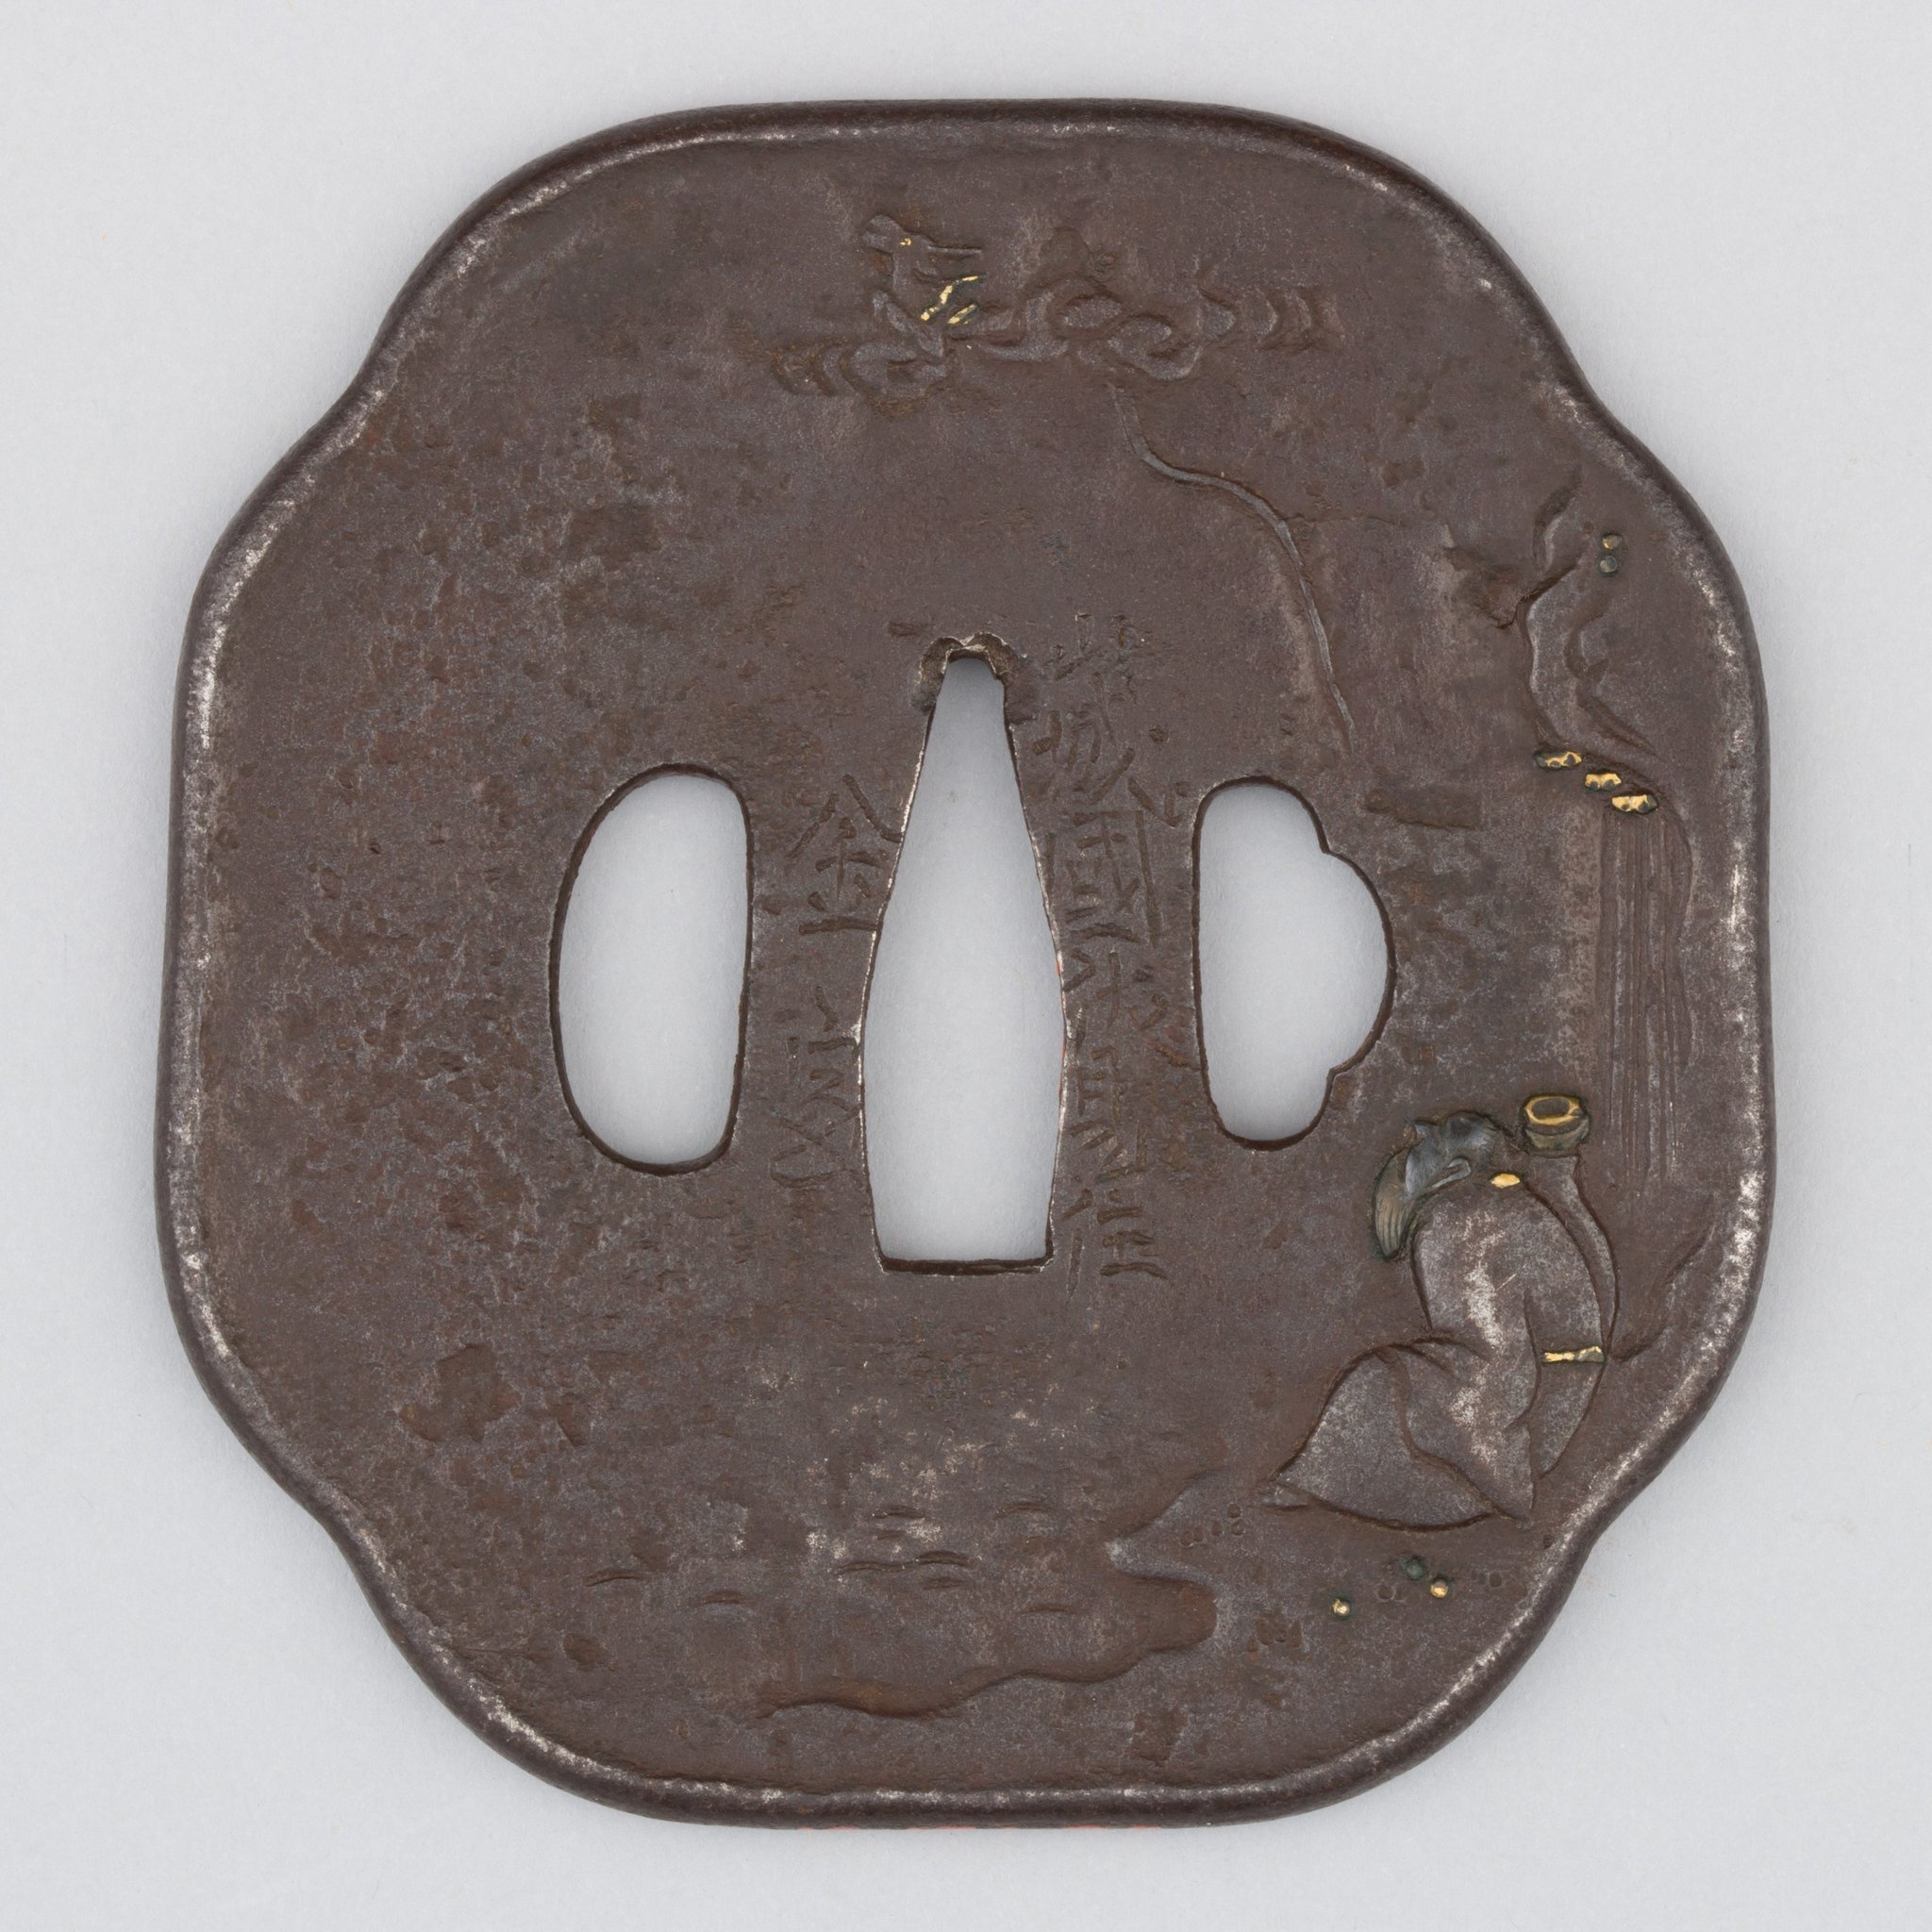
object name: sword guard tsuba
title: Sword Guard (Tsuba)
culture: japanese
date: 1801-1900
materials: copper, gold, iron, silver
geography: japan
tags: men